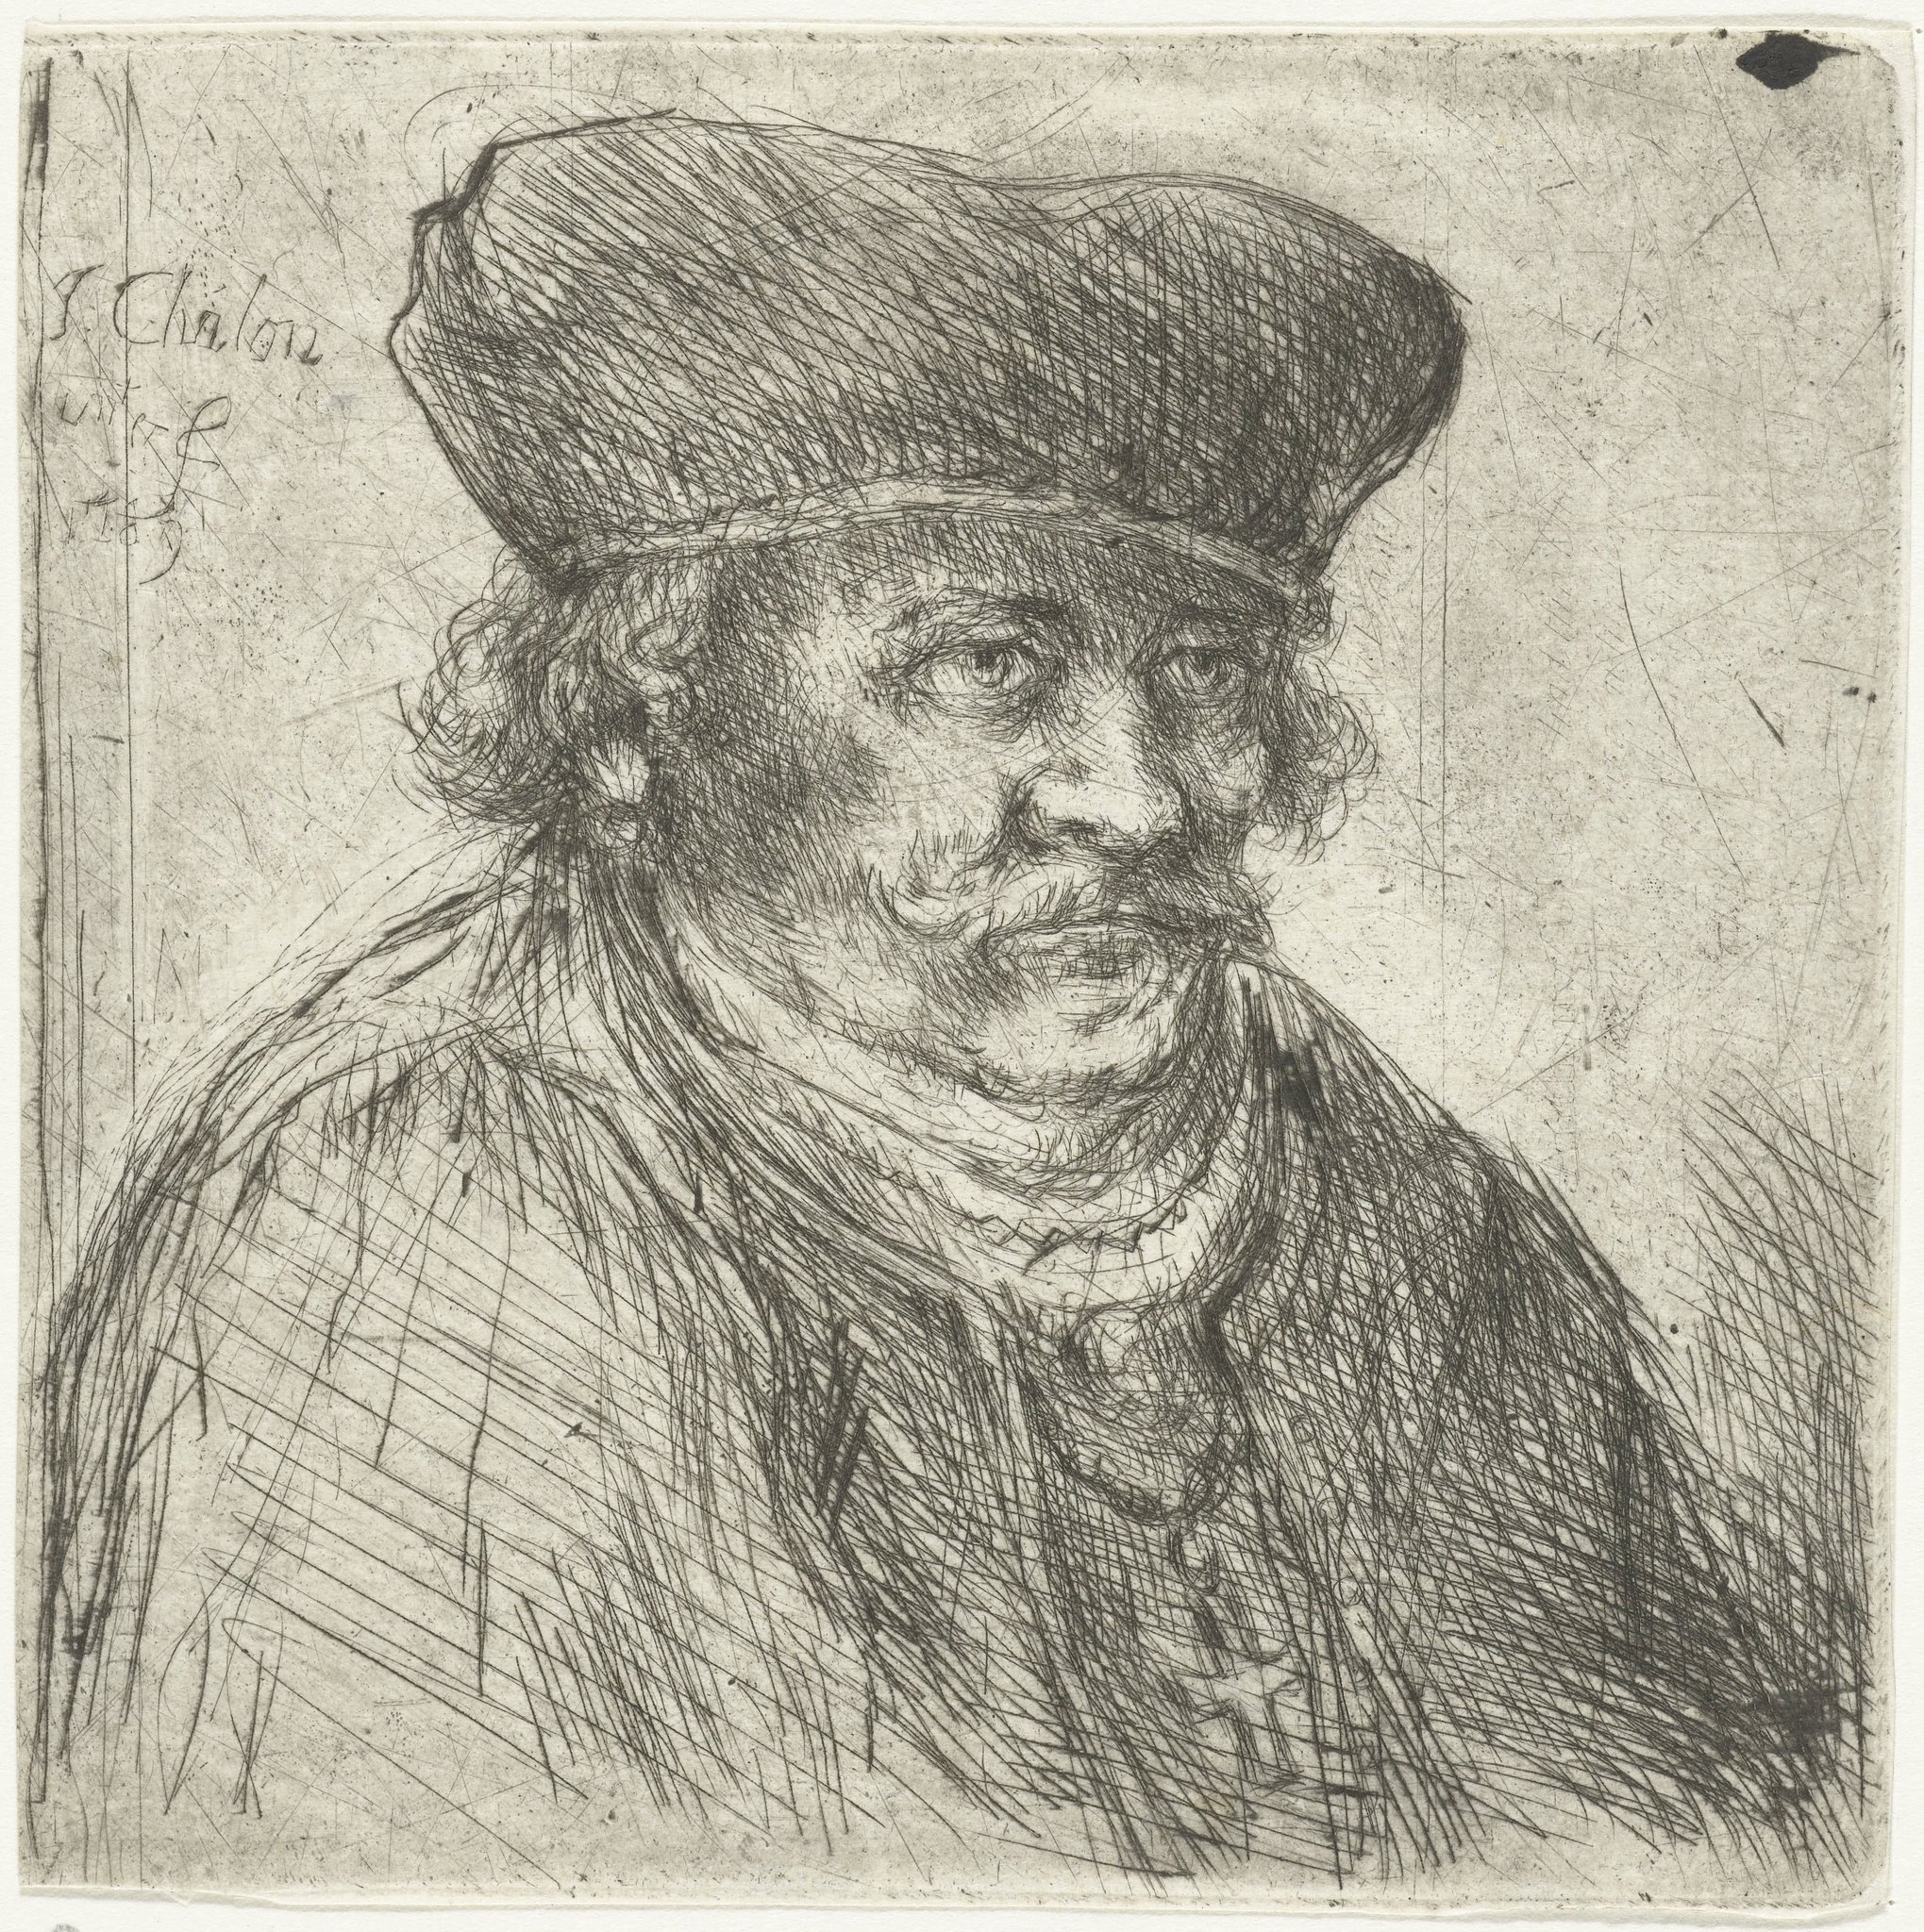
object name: print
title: Oude man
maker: jan chalon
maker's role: print maker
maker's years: 1738-1795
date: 1789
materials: paper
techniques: drypoint, etching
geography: northern netherlands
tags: morphology of human expression (+ adult male (human being))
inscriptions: date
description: Een volwassen man met hoed. Buste naar rechts.